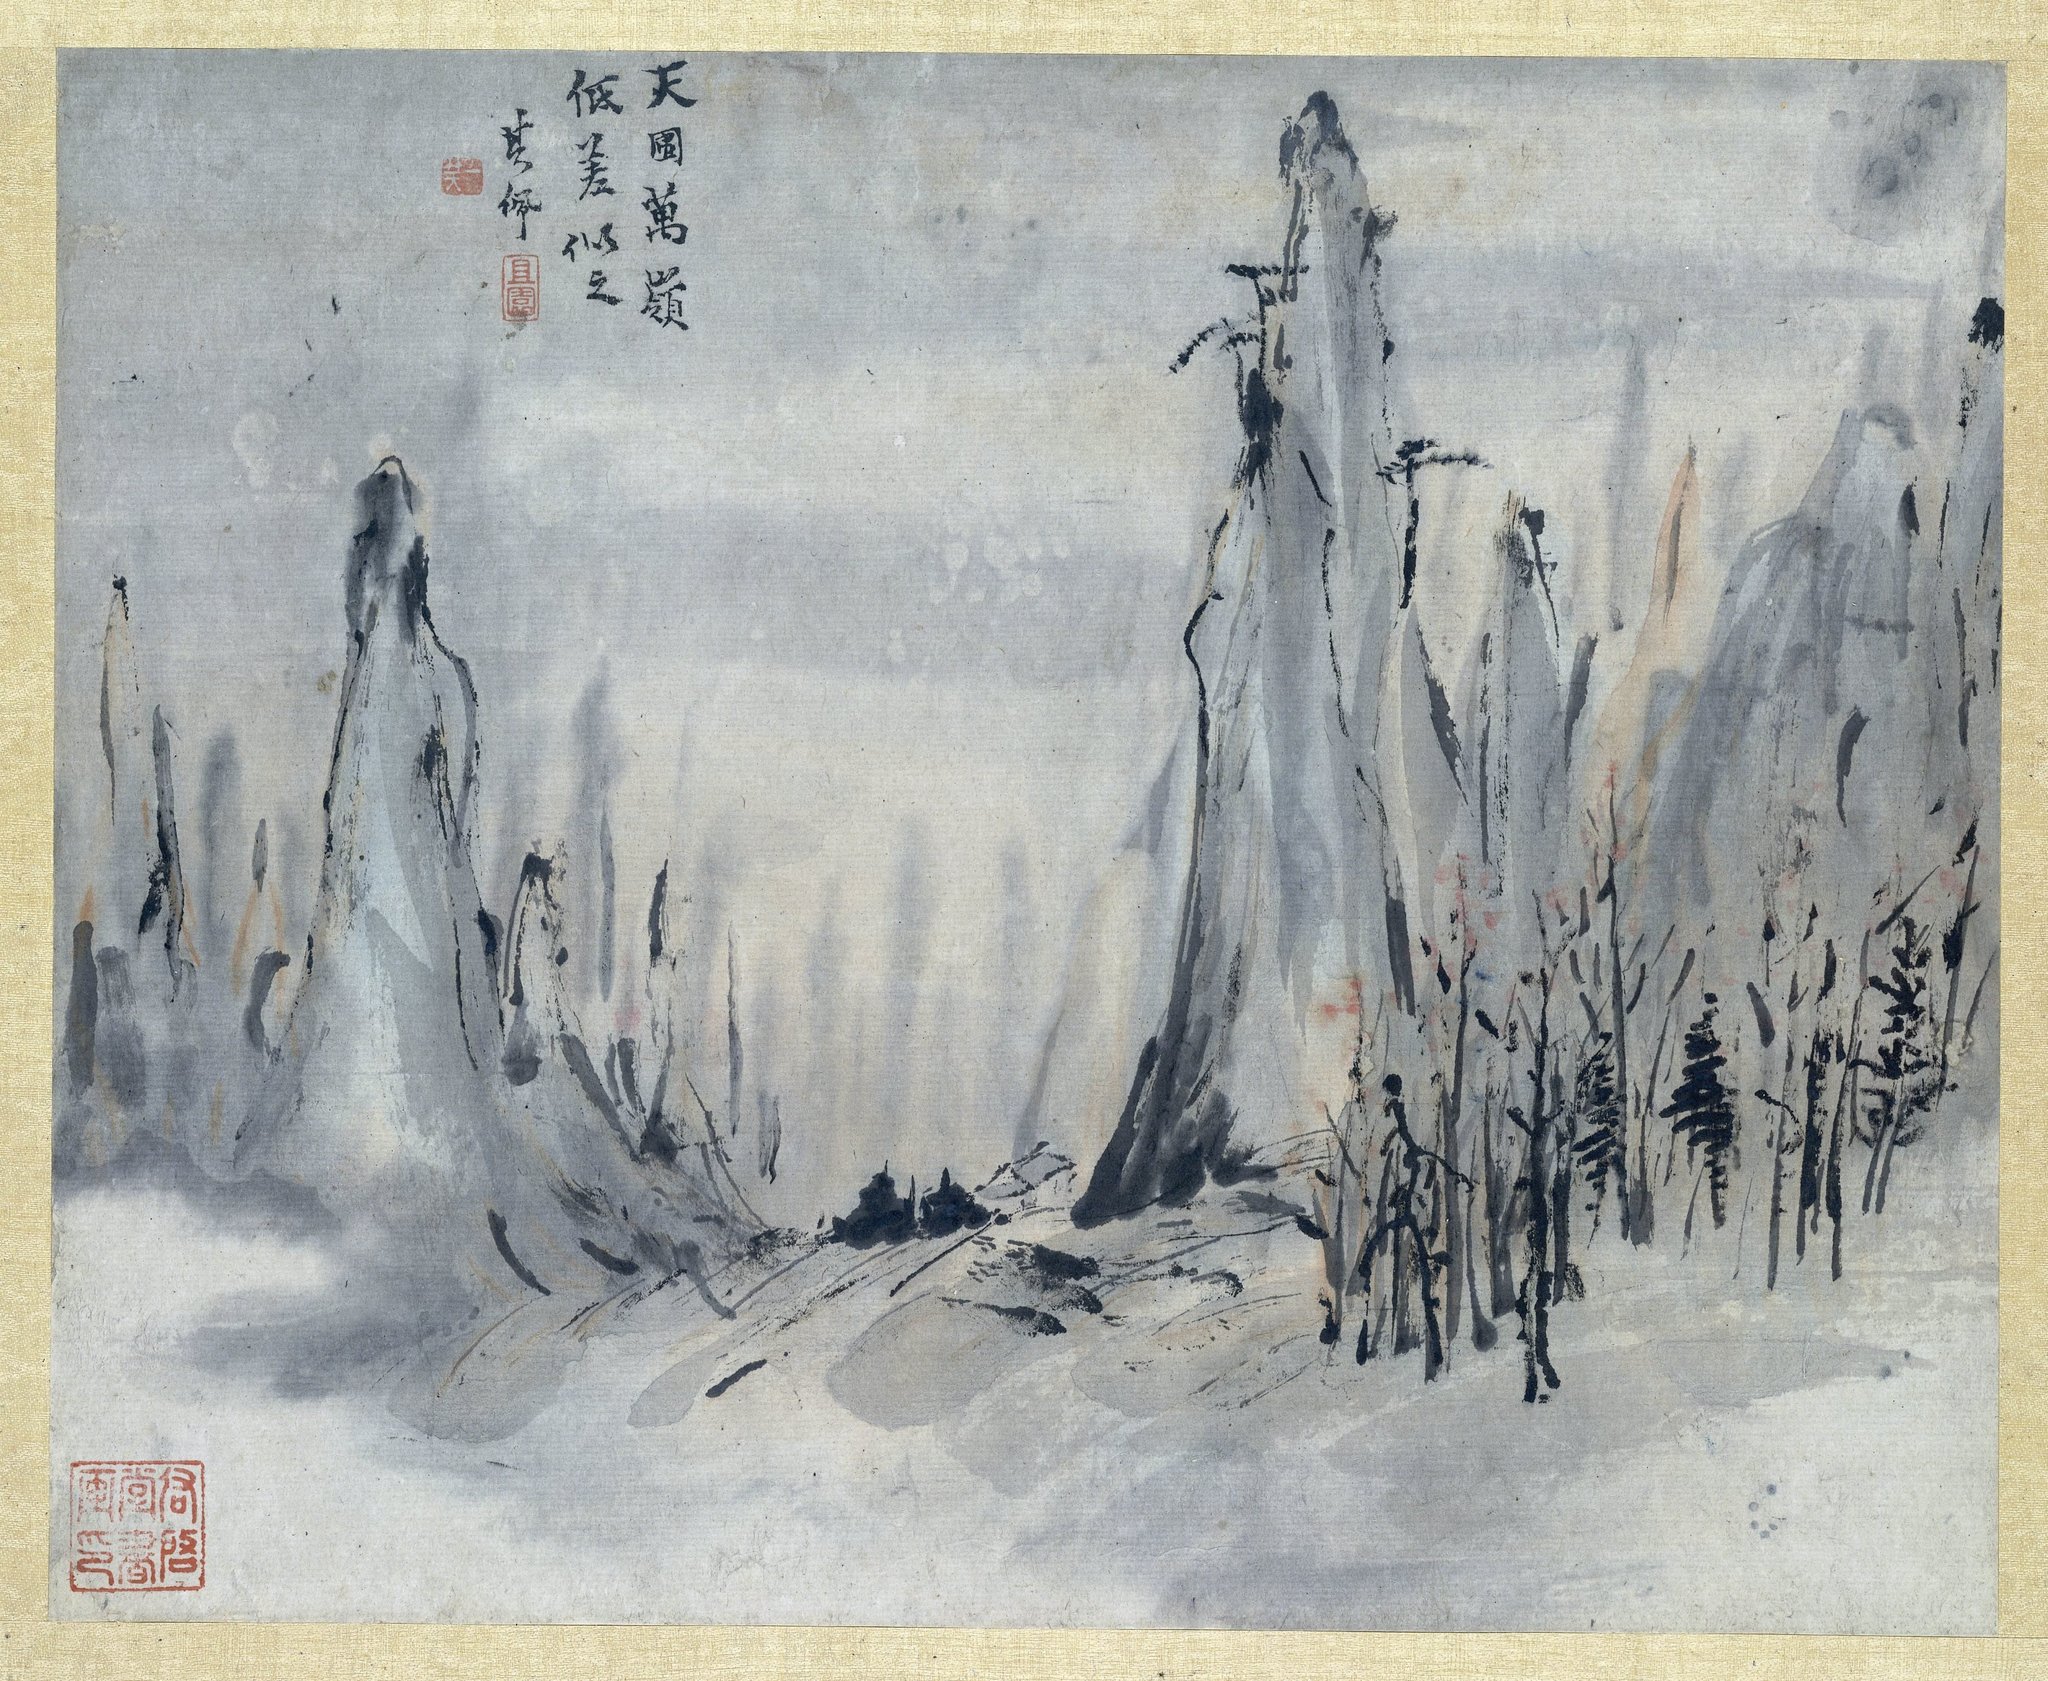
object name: finger painting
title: Schildering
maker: gao qipei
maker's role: painter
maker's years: 1661-1734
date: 1700-1750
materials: dye, ink, paper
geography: china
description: Eén van twaalf landschappen, vingerschildering met opschrift van de schilder Gao Qipei (1662 - 1731(?)). Opmerking: Zie inv. nr. AK-MAK-290.